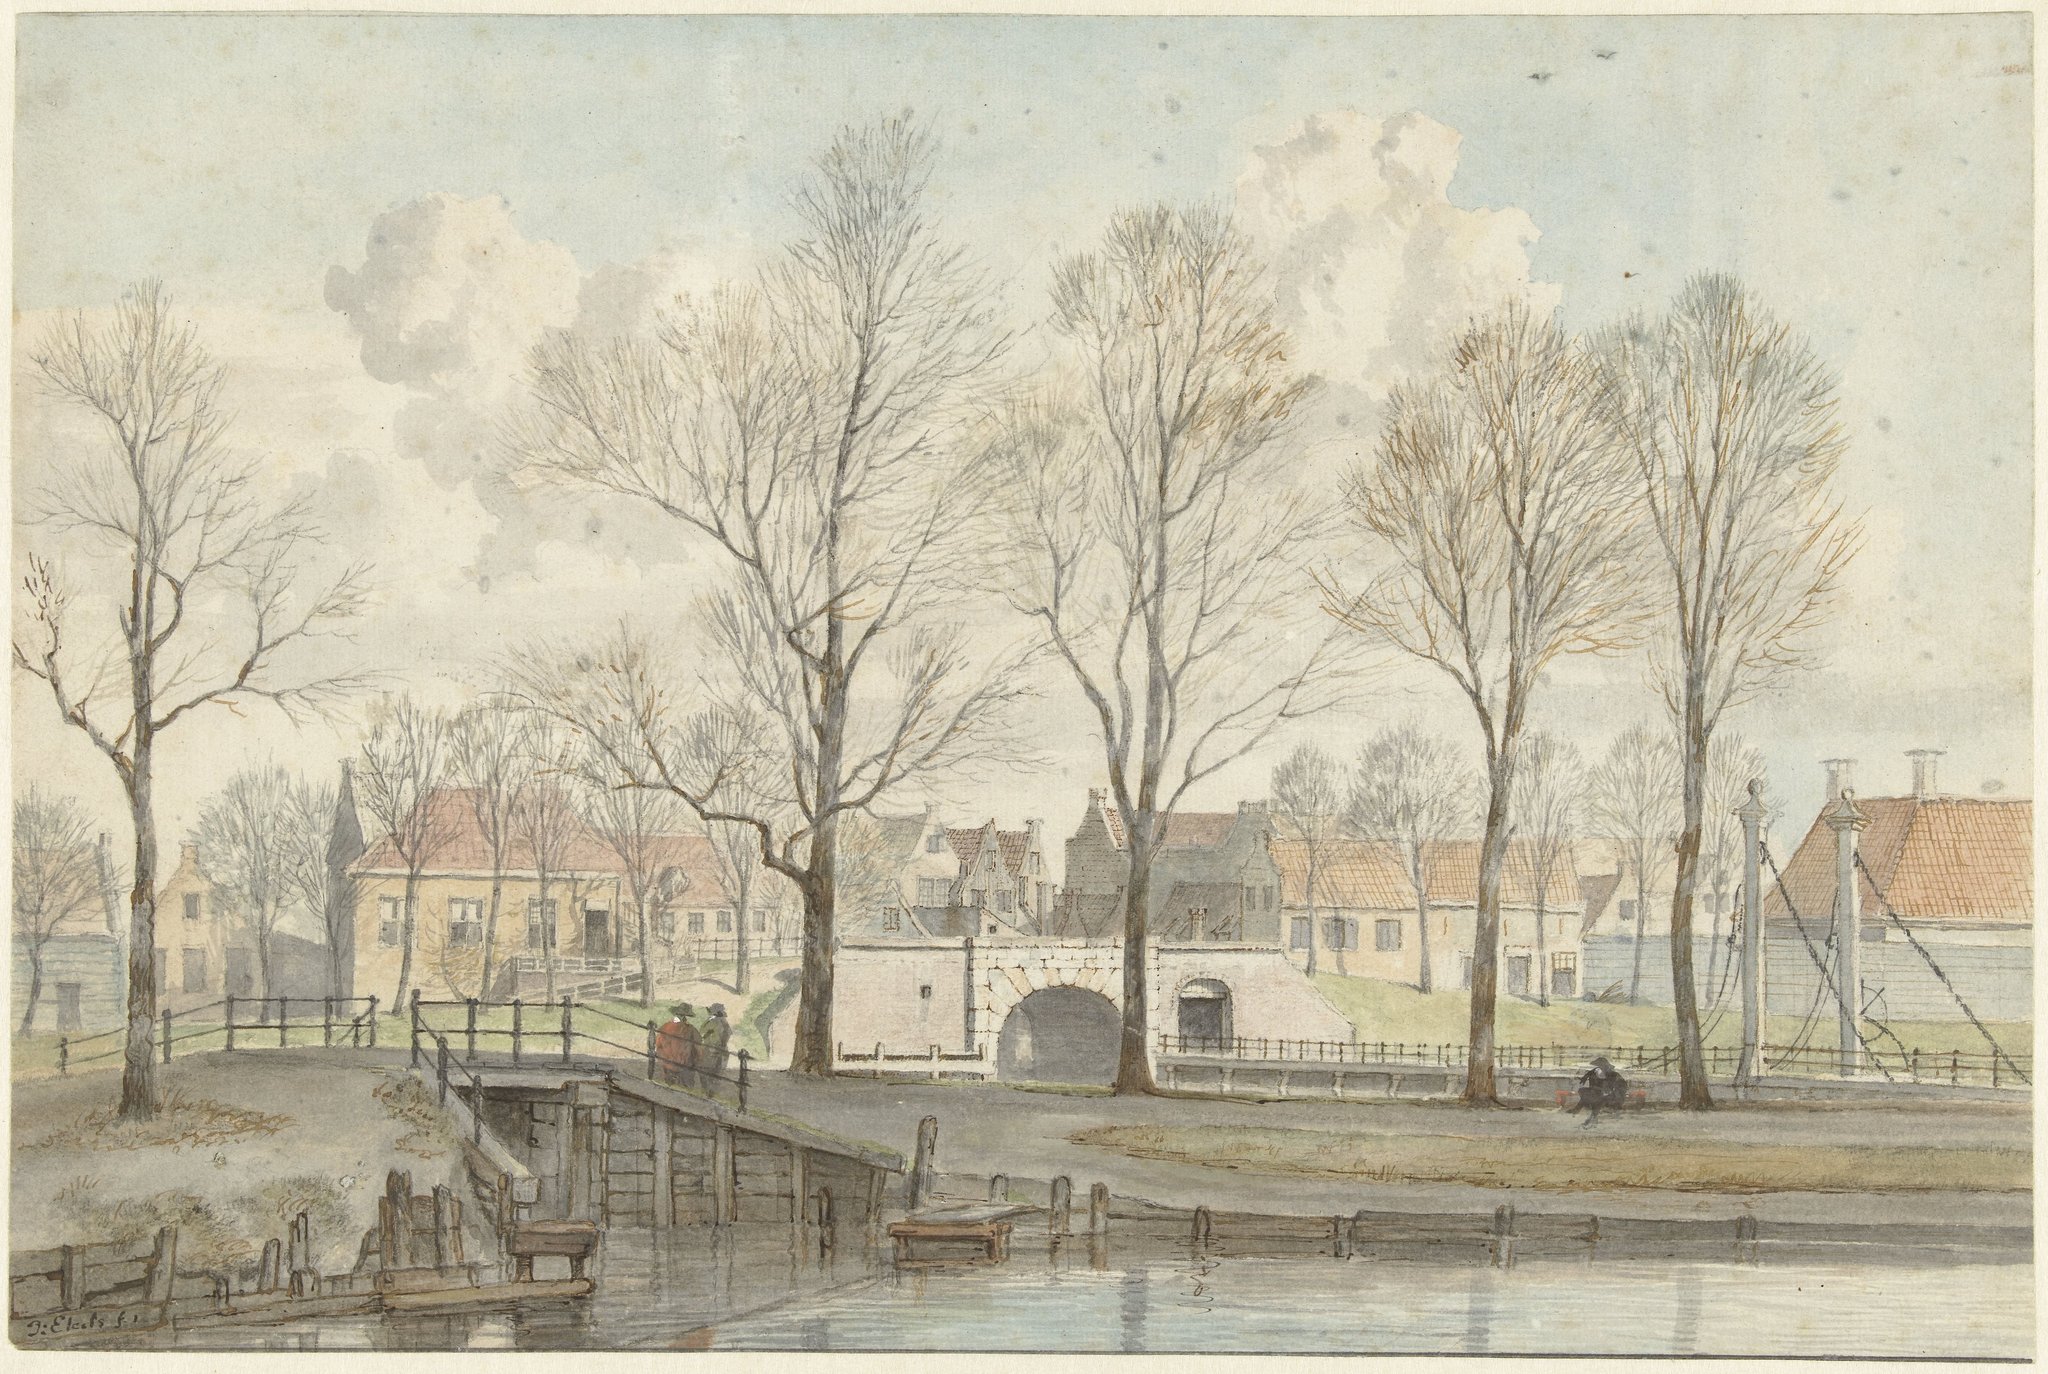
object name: watercolor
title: De Heerenpoort te Leiden (?)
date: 1734-1781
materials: chalk, ink, paper, watercolor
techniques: brush, pen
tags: city-gate, leiden